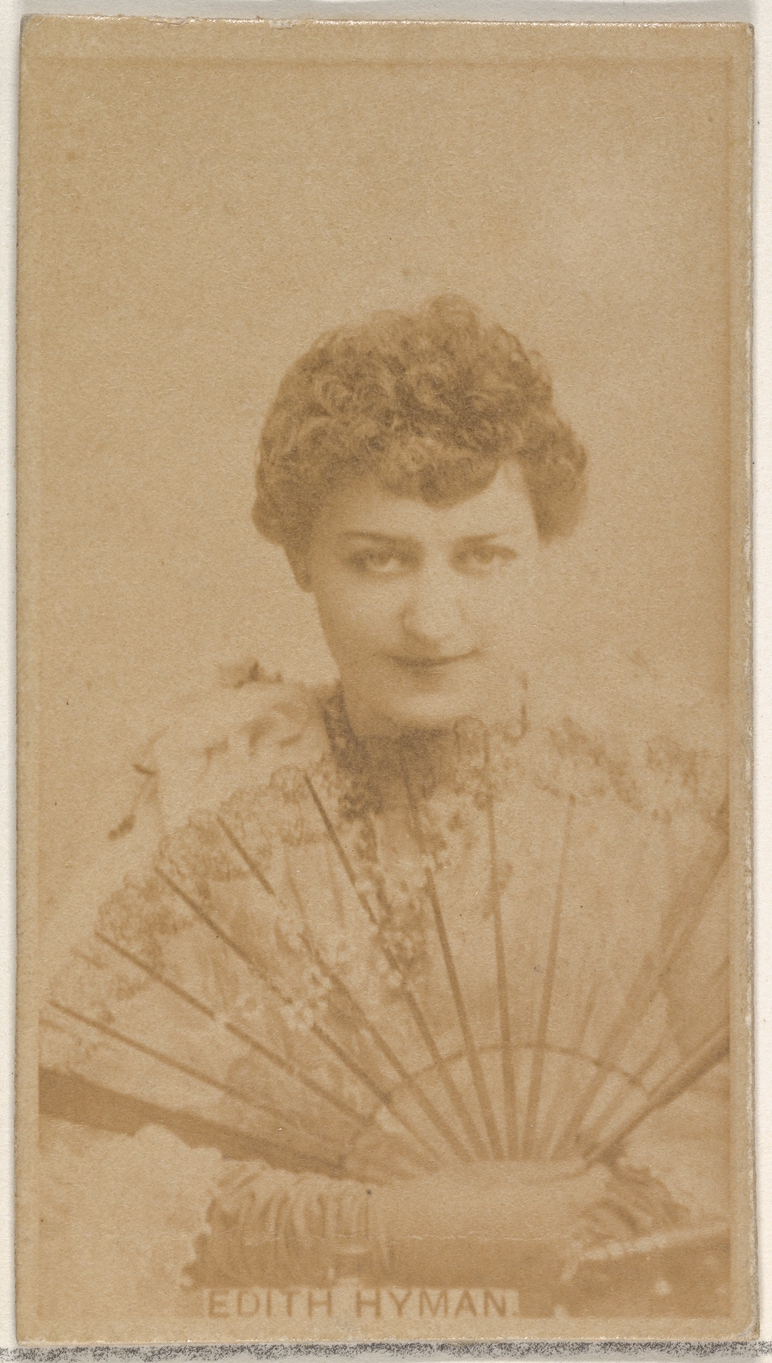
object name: photograph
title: Edith Hyman, from the Actors and Actresses series (N45, Type 8) for Virginia Brights Cigarettes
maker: allen & ginter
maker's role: publisher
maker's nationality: american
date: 1888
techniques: albumen silver print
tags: fans,portraits,women,actresses